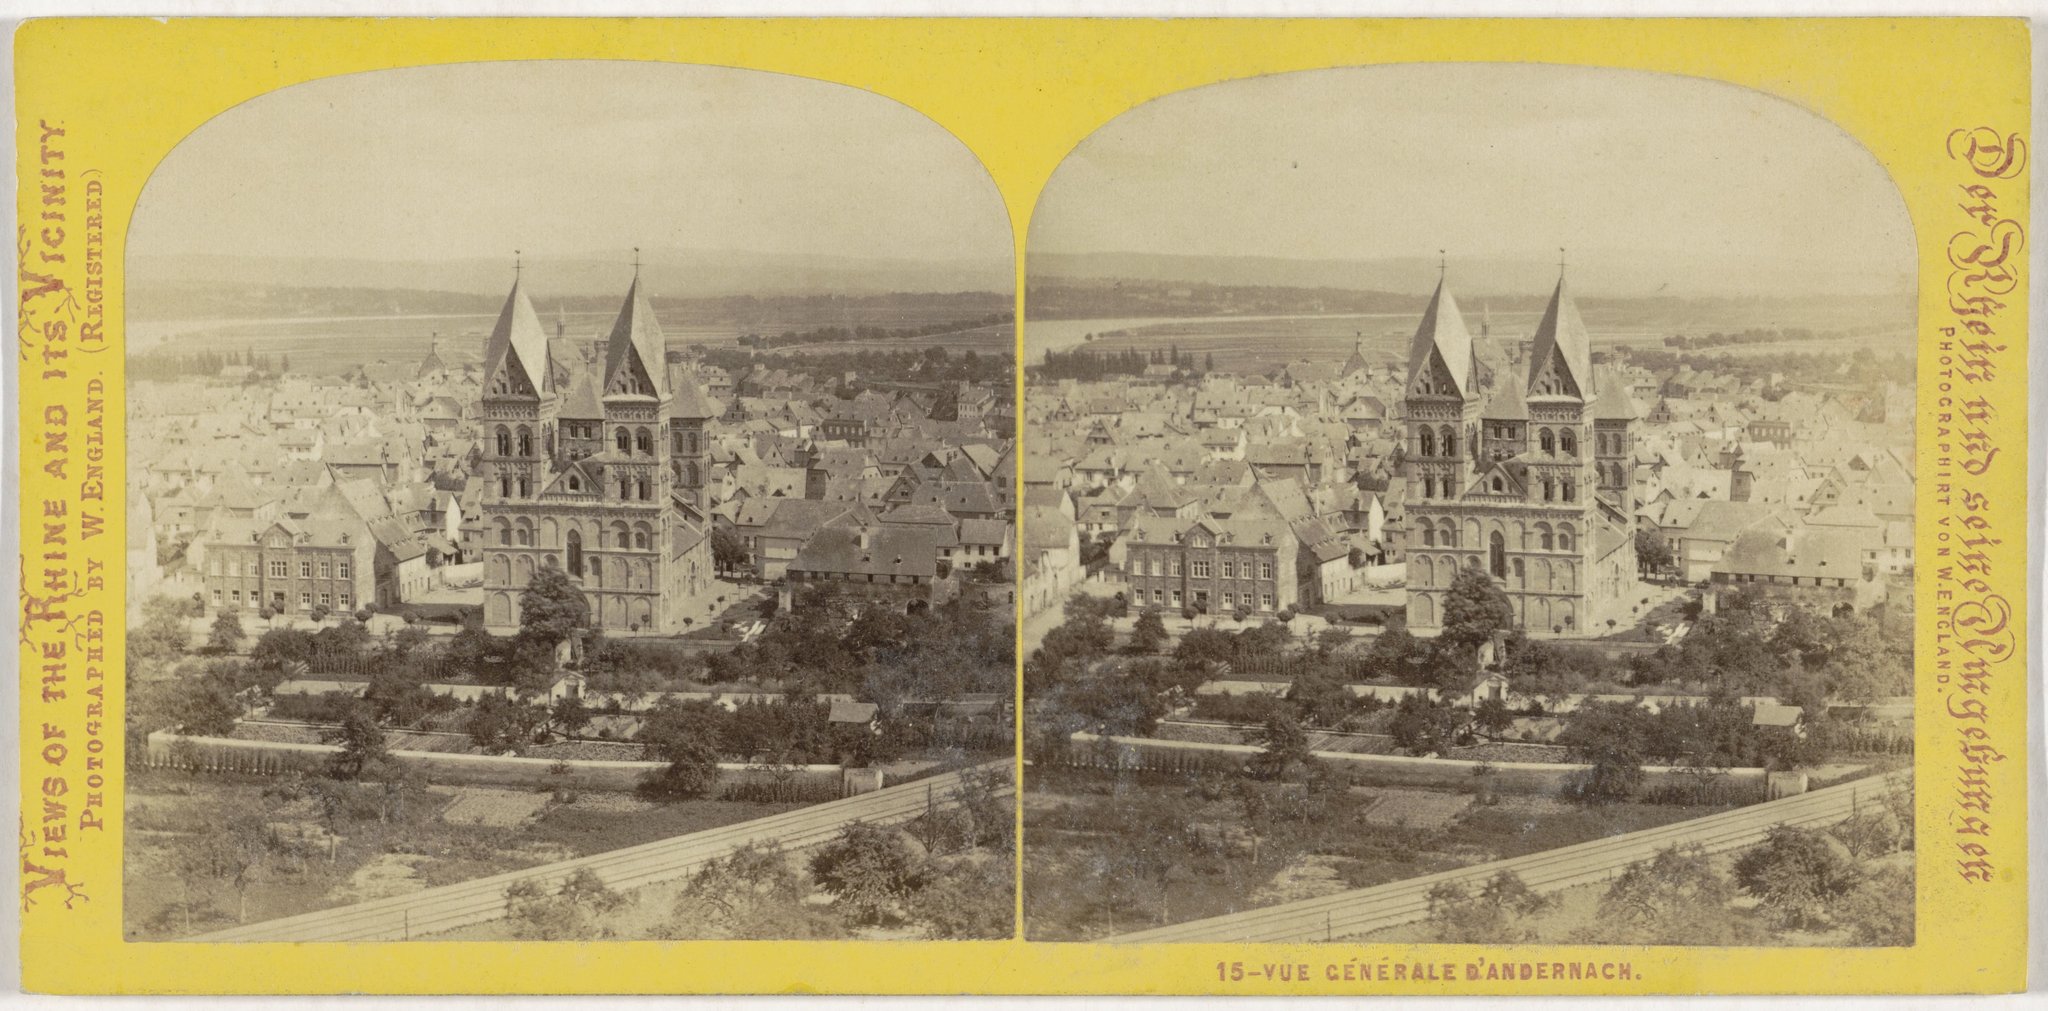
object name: stereograph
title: Vue générale d'Andernach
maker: william england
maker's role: fotograaf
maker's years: 1816-1896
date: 1867-1868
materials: cardboard, paper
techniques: albumen print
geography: andernach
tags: prospect of village, silhouette of village, church (exterior)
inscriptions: number: ‘15’, inscription: ‘(Registered)’